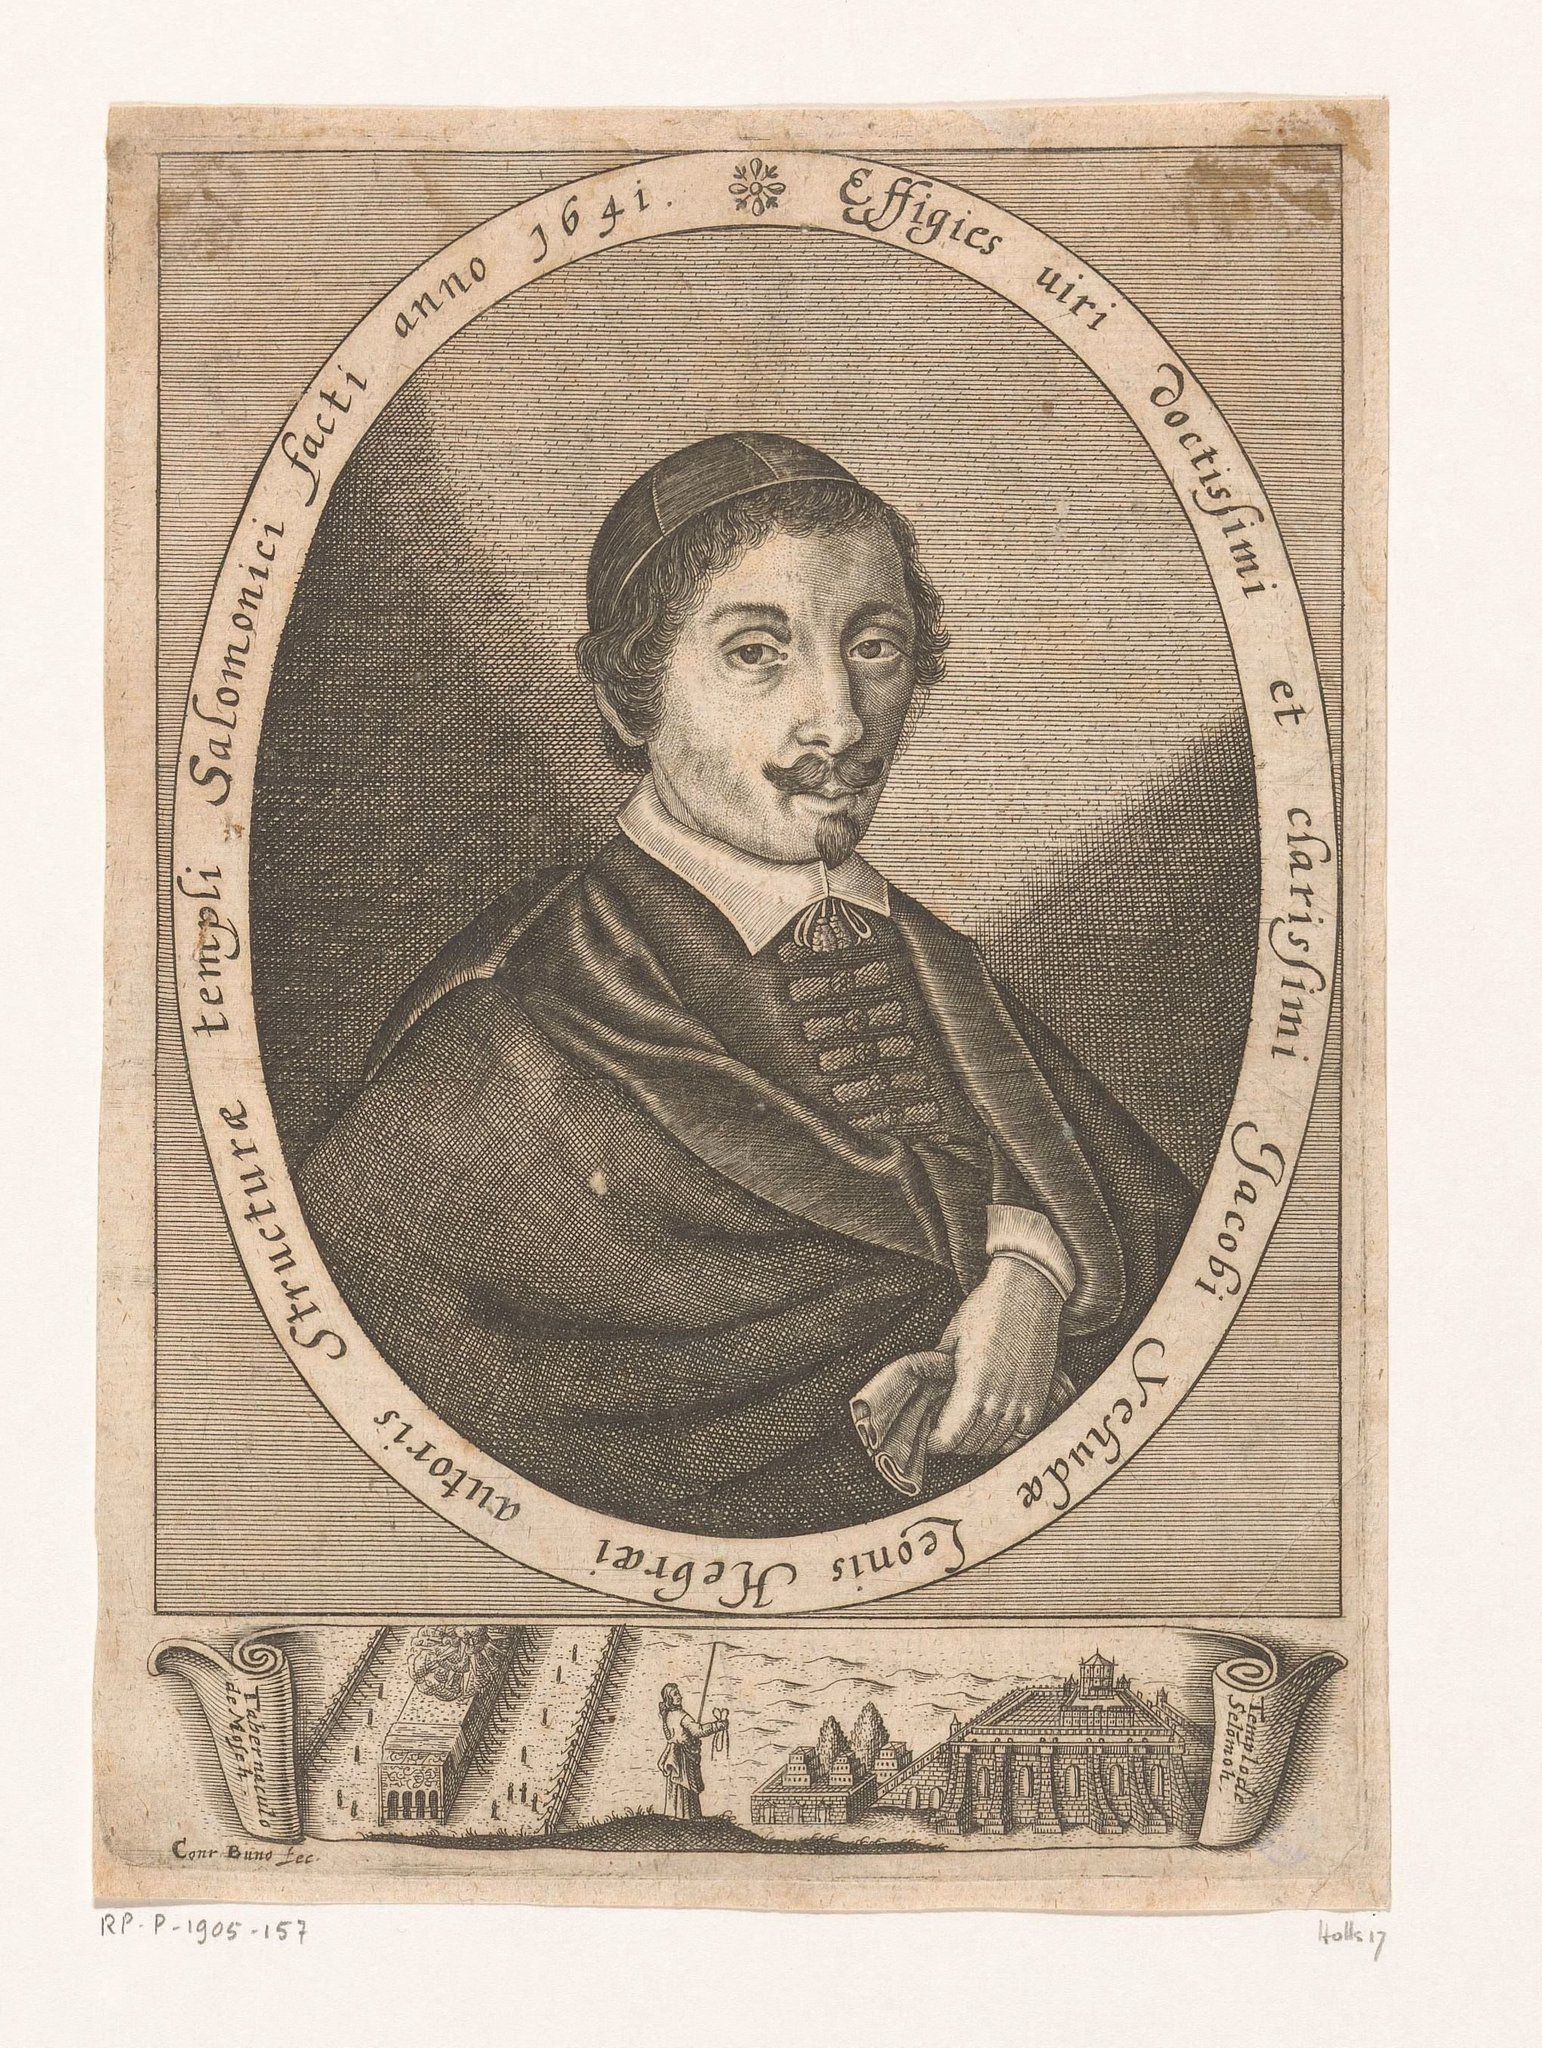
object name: print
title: Portret van Jacob Jehuda Leon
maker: conrad buno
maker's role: print maker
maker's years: 1616-1671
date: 1641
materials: paper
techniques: engraving, etching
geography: braunschweig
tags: amsterdam, historical persons, underclothes and nightwear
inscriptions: collector's mark: Lugt 2228